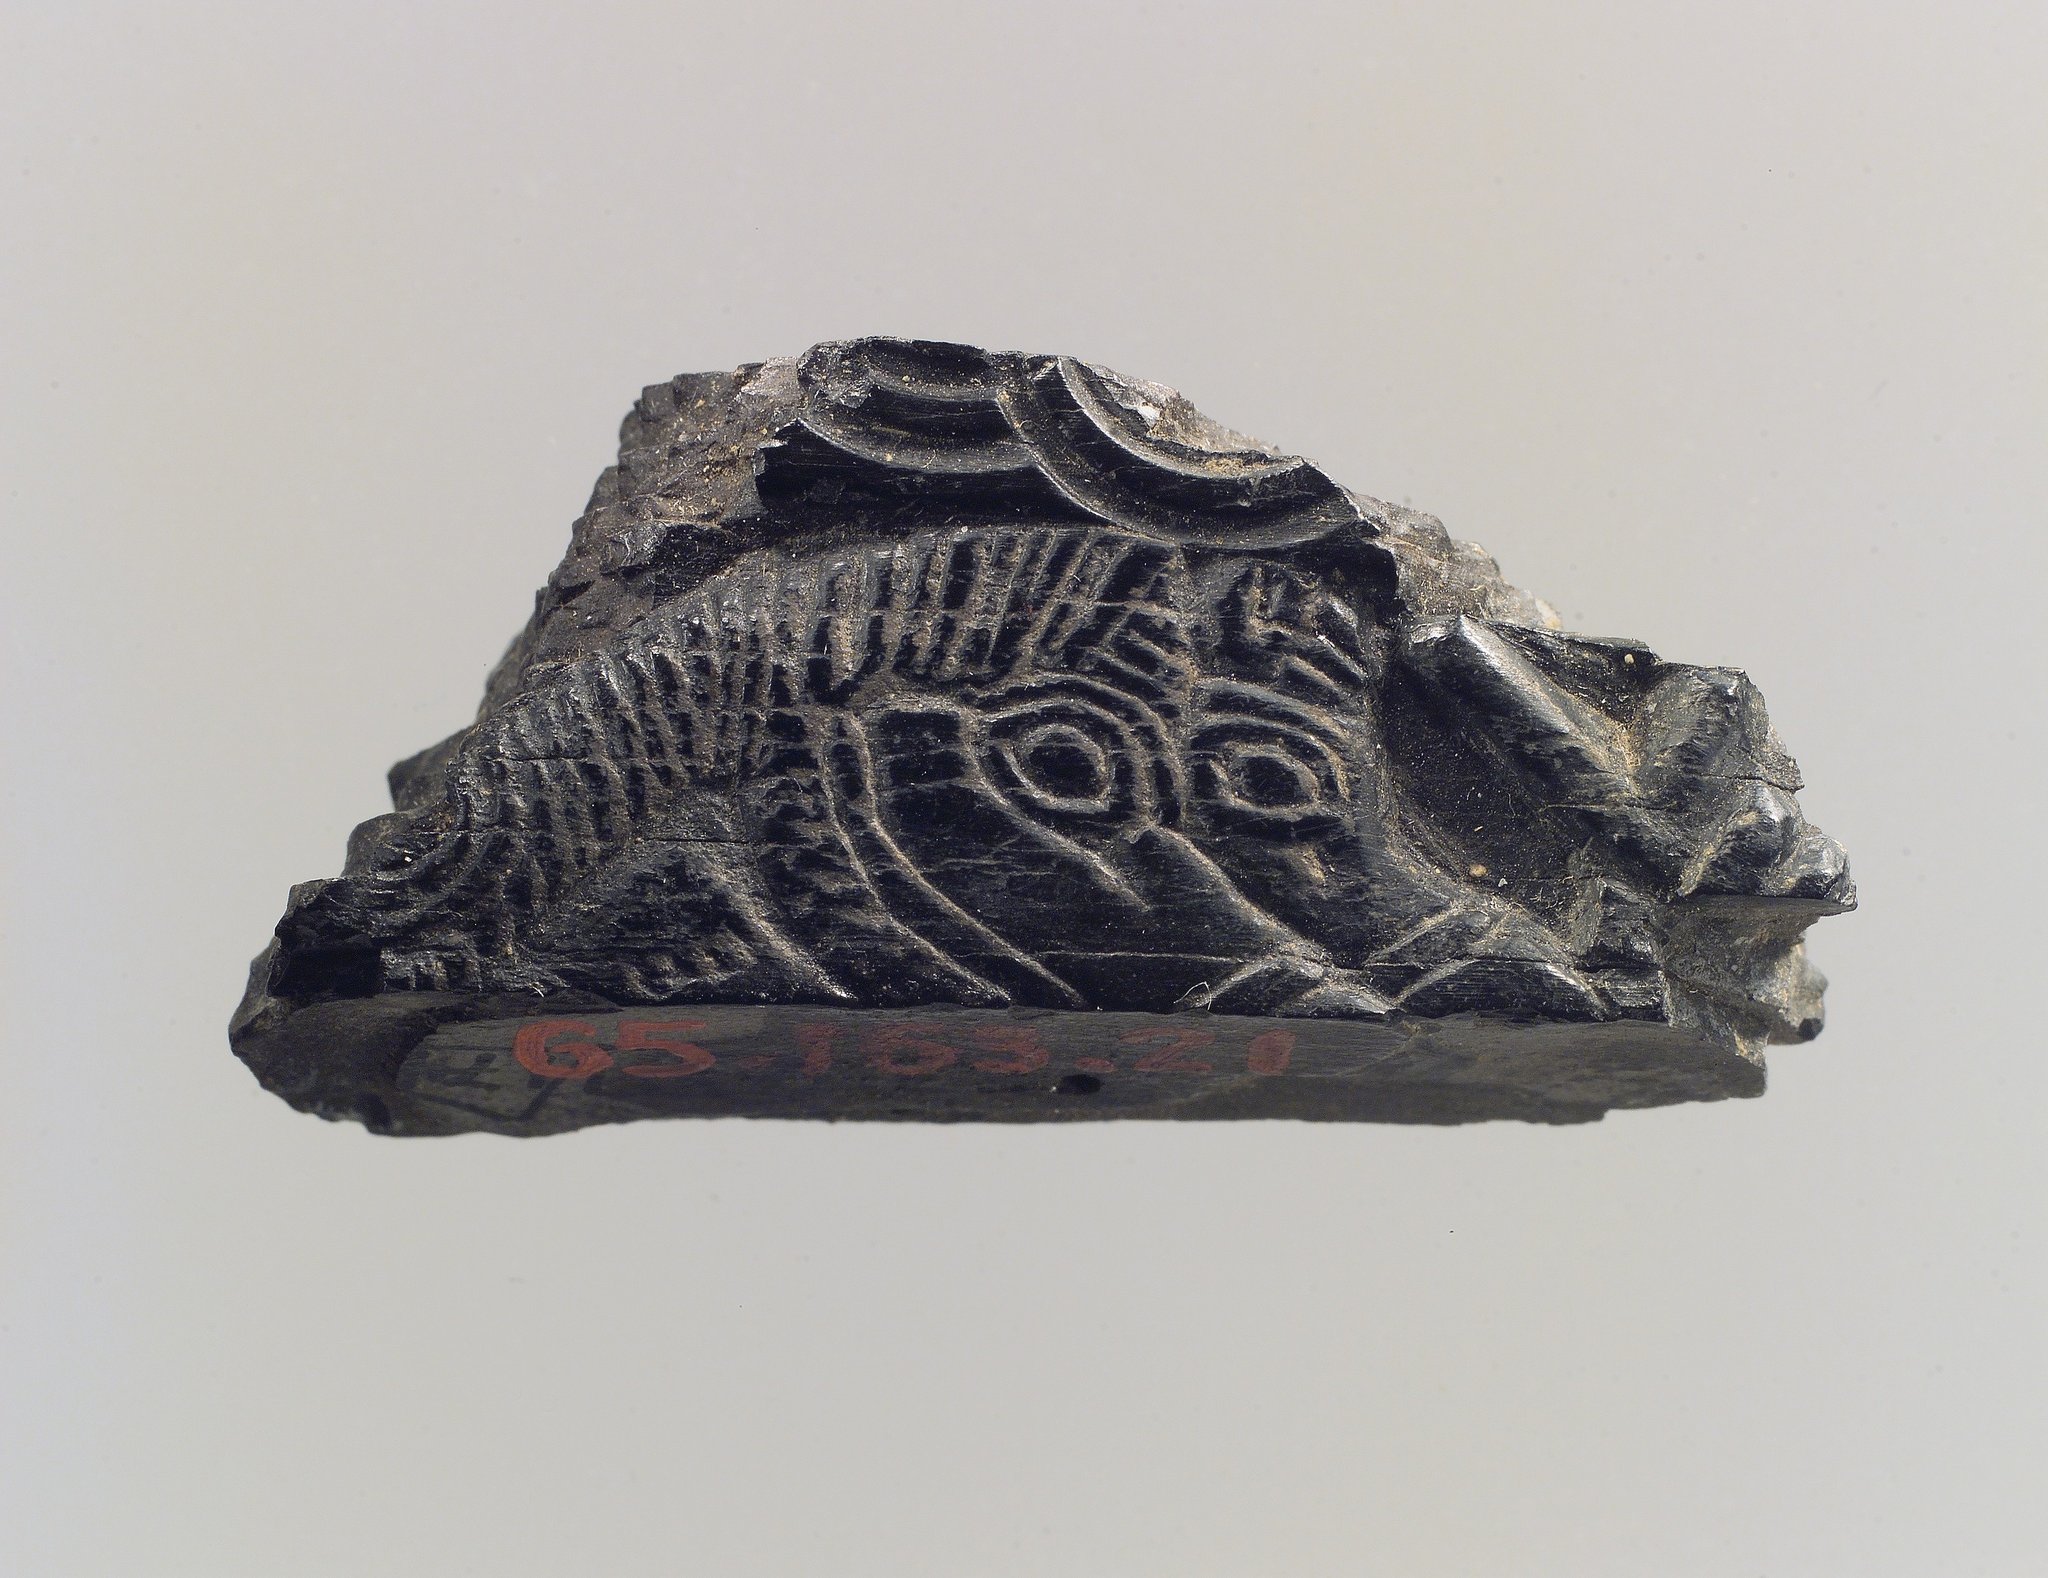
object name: relief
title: Plaque fragment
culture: iranian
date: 900-801 BCE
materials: ivory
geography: iran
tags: eyes